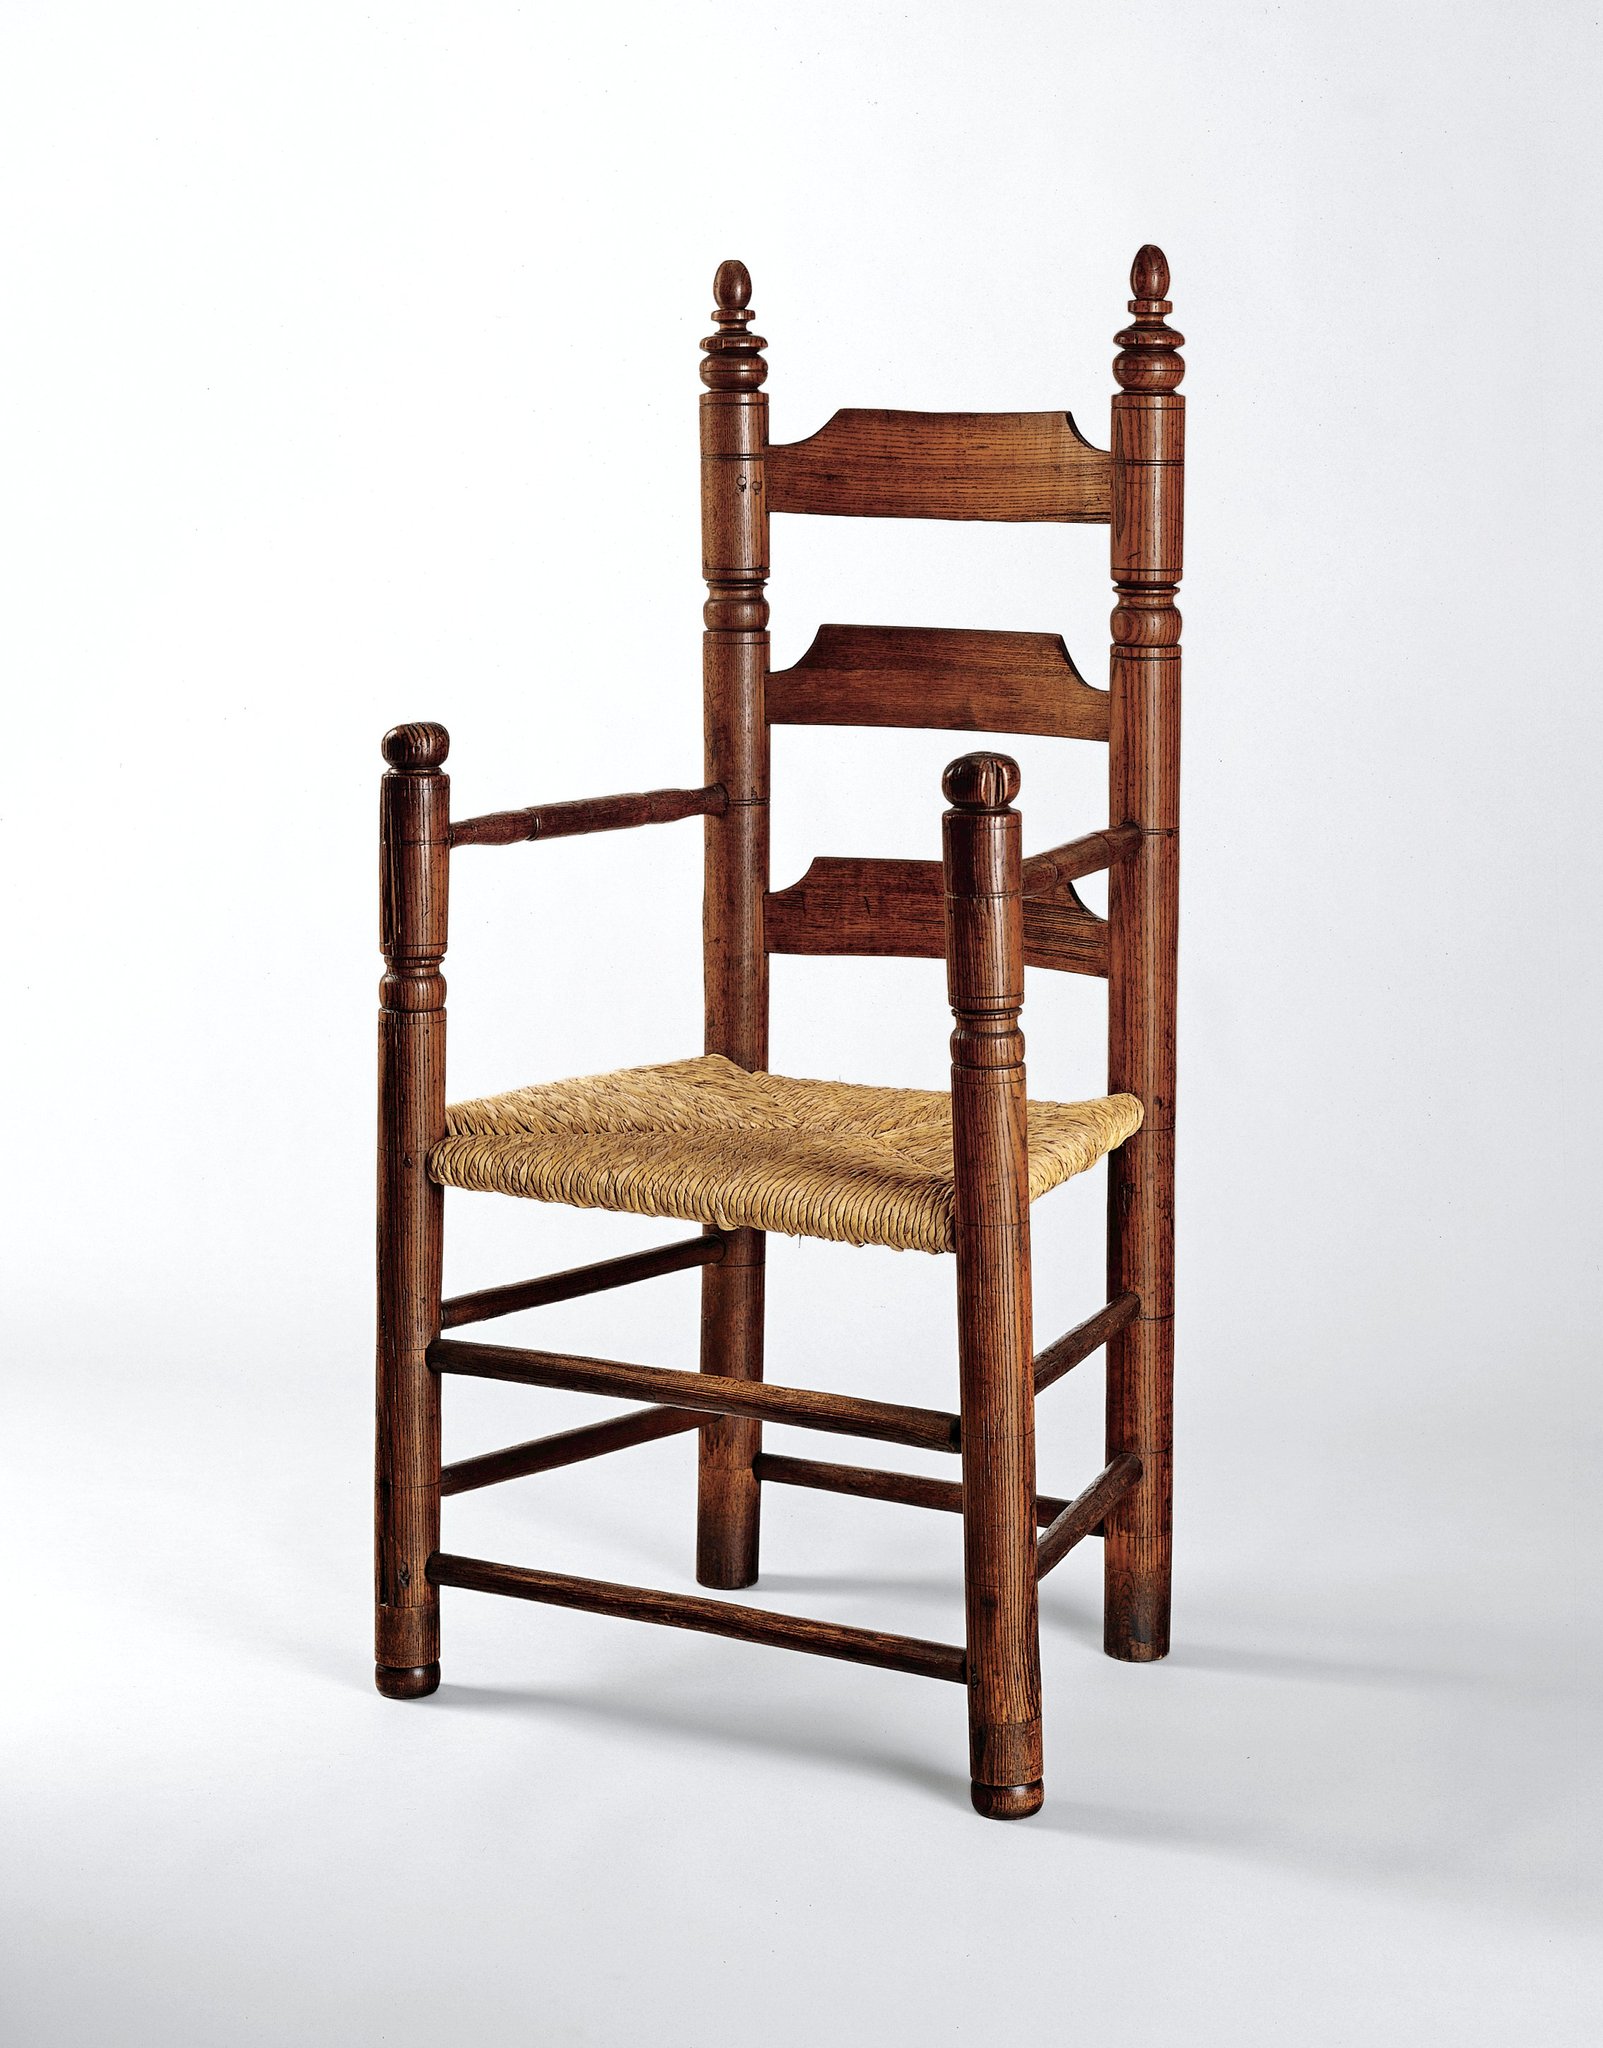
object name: armchair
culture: american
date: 1650-1700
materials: wood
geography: united states